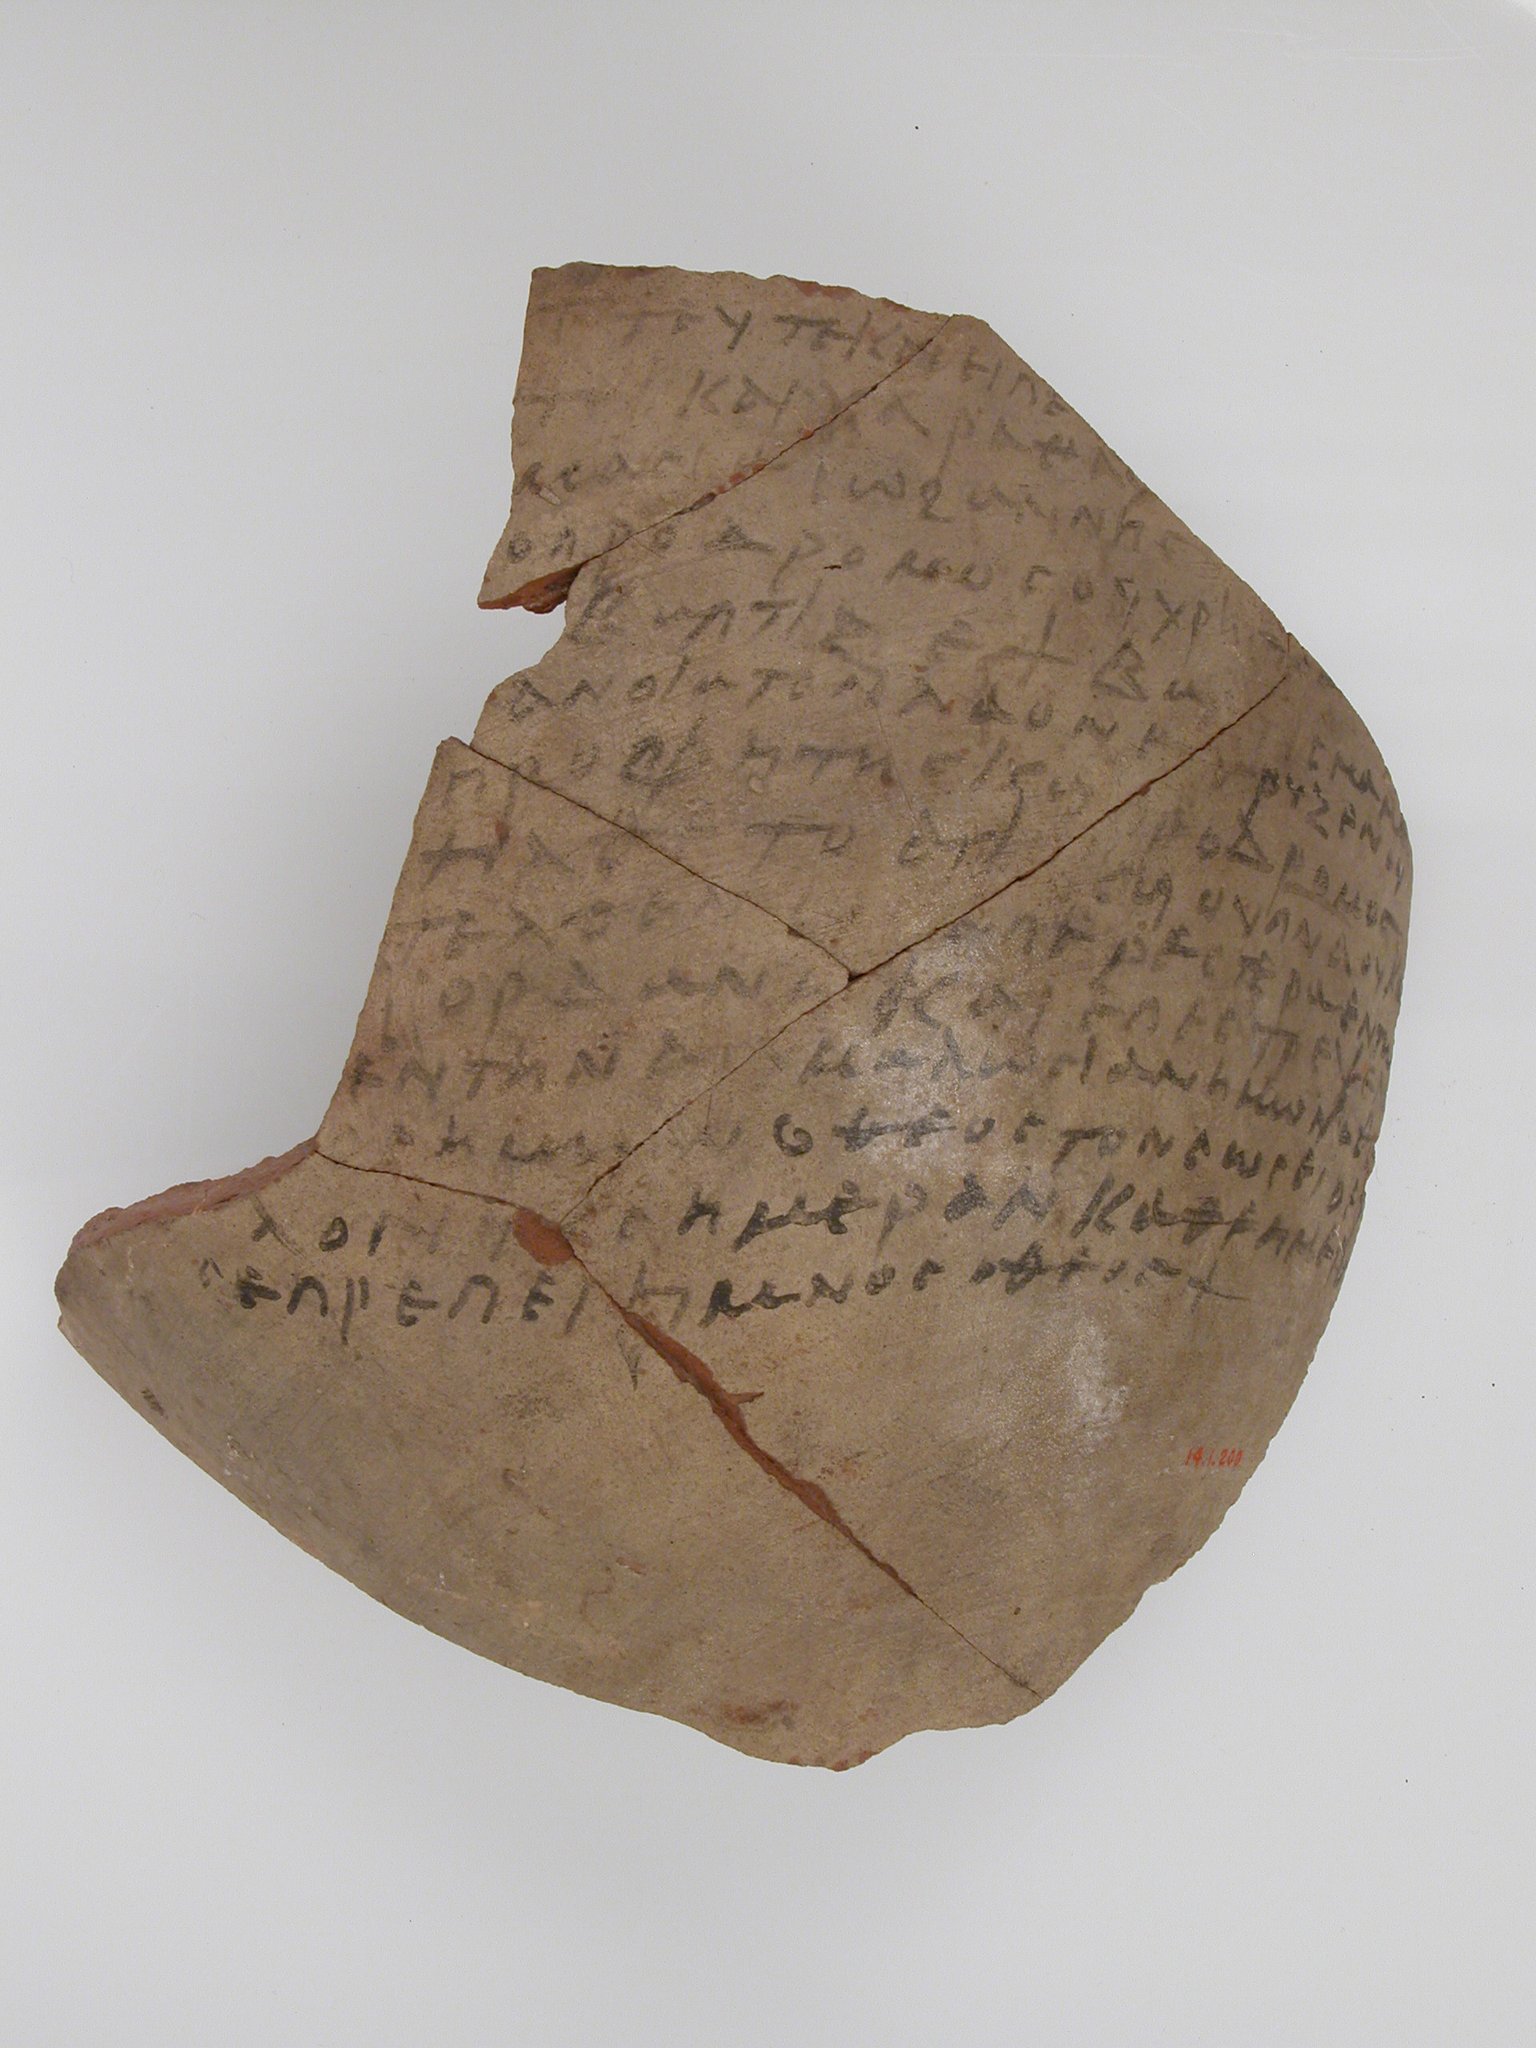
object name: ostrakon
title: Ostrakon with Troparion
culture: coptic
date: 580-640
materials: ink, pottery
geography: egypt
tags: greek